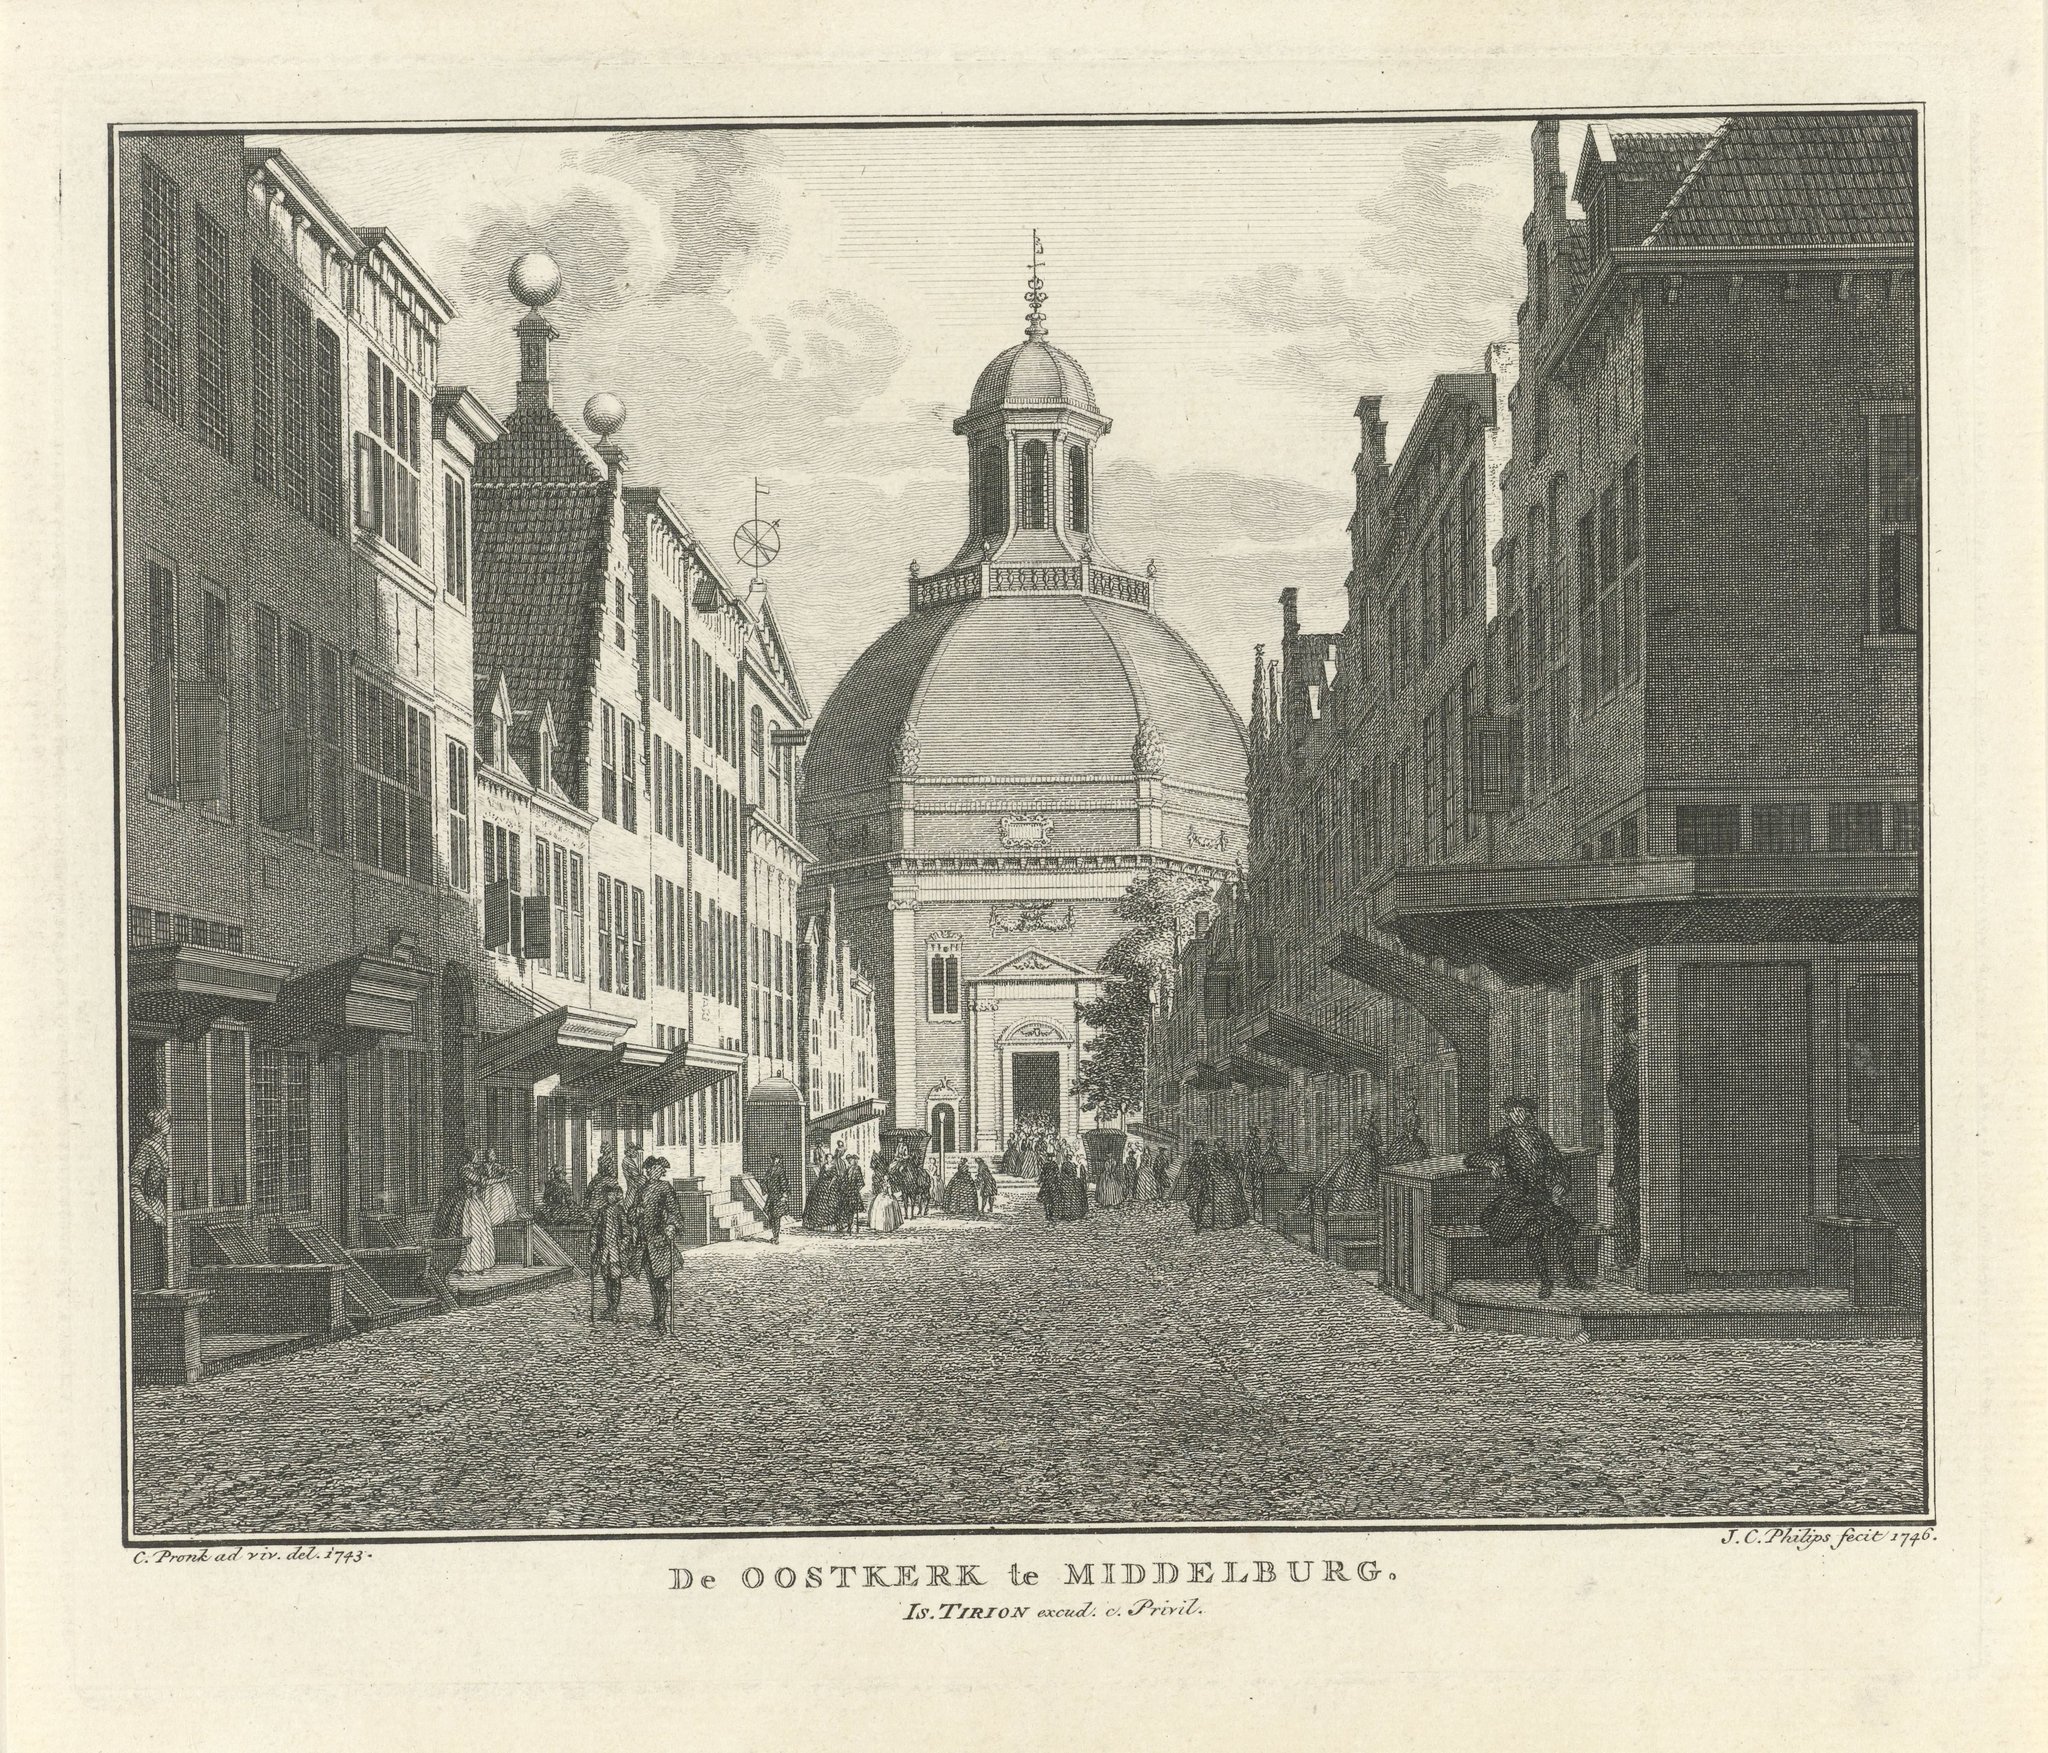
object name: book illustration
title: De Oostkerk te Middelburg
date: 1746-1760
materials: paper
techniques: etching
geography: amsterdam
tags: church (exterior)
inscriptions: collector's mark: Lugt 2228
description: Gezicht op de Oostkerk te Middelburg, in de situatie omstreeks 1743.